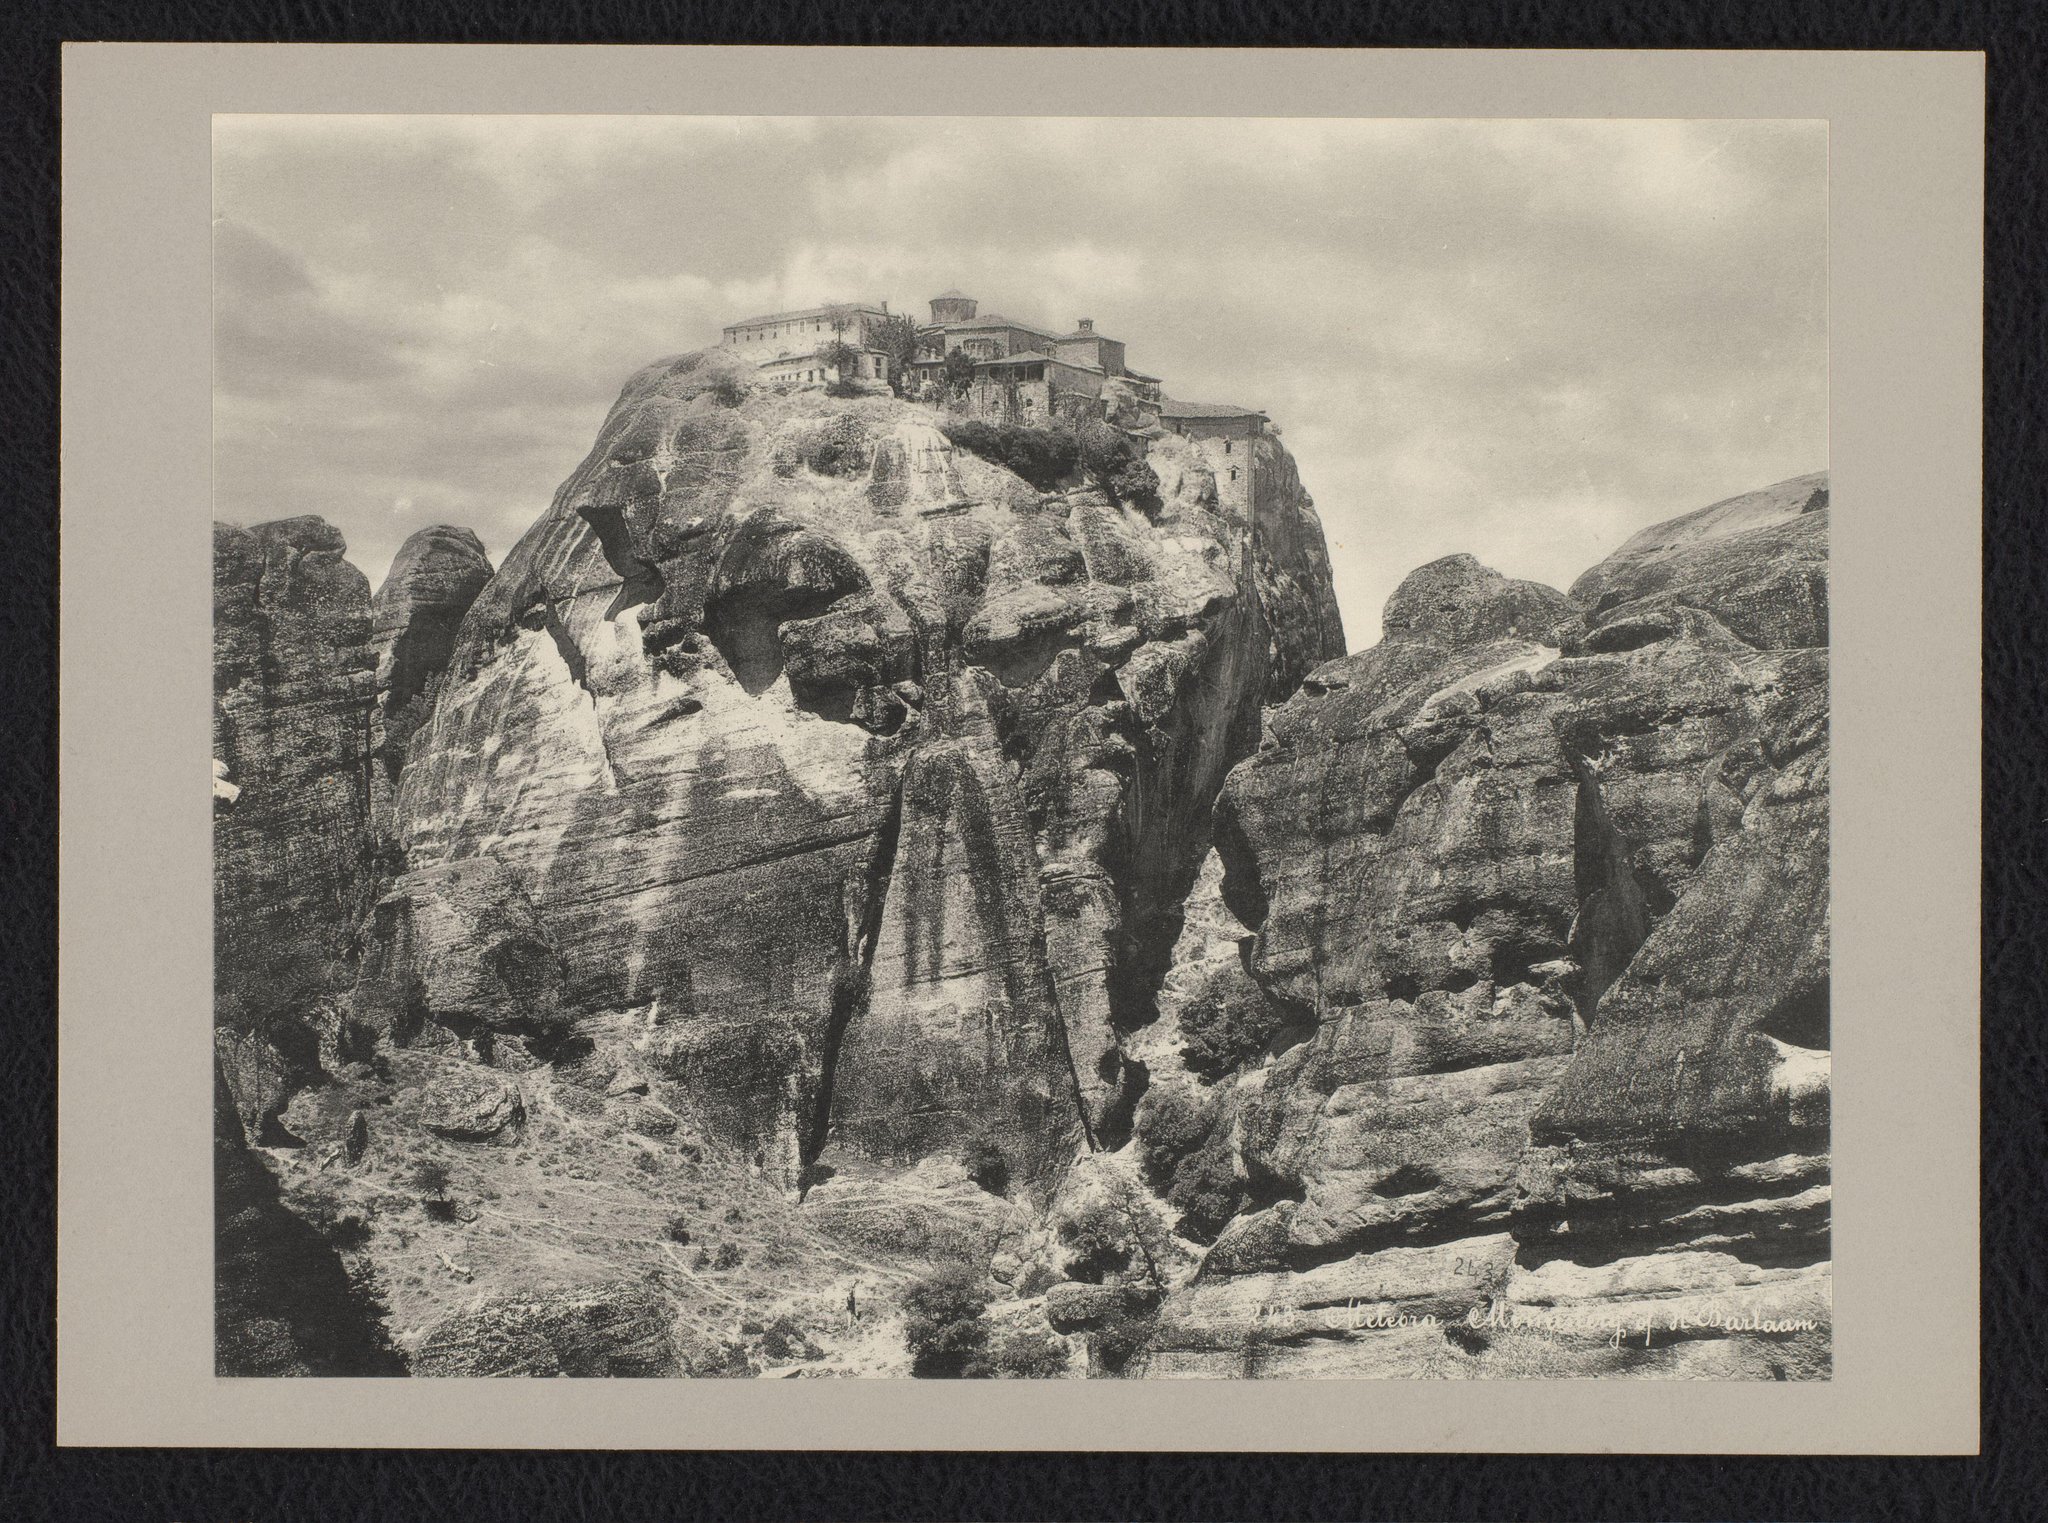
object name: photograph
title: 243 Meteora Monastery of H Barlaam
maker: Anonymous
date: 1895-1915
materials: cardboard, paper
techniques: photograph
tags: thessalië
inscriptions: number: ‘47.’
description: Boven de titel staat het nummer 243 geschreven met zwarte inkt.